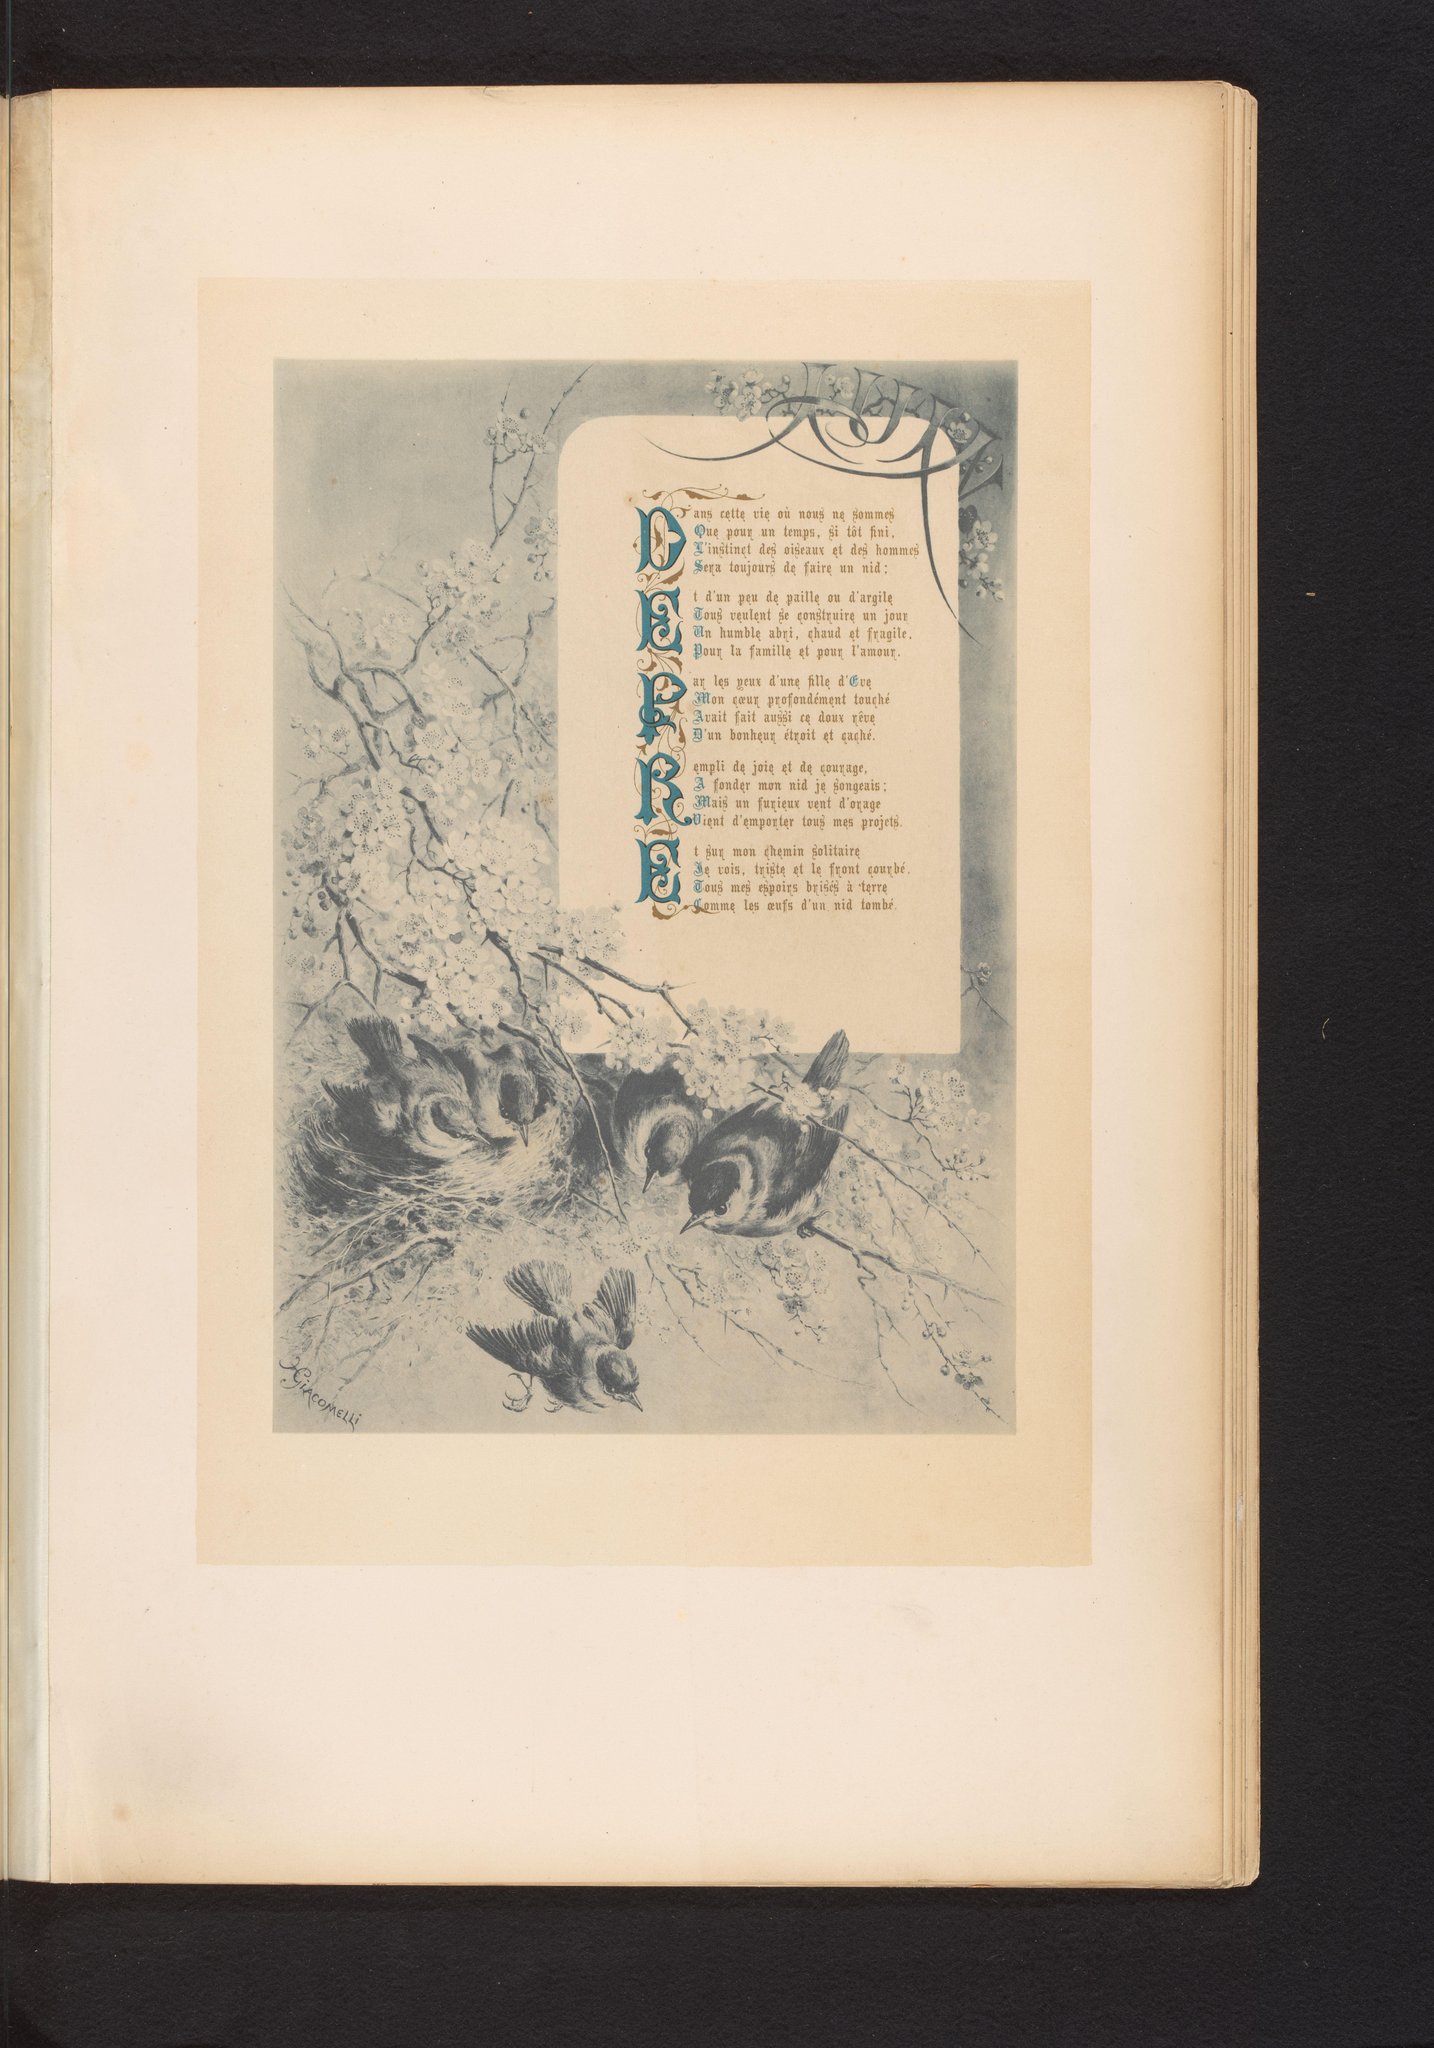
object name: photomechanical print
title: Reproductie van een prent van vogels die hun jong zien uitvliegen, met het gedicht Juin van François Coppée, door Hector Giacomelli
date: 1871-1876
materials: paper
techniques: chromolithography, photograph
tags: birds, animals (+ nest, den, burrow), june ~ other concepts